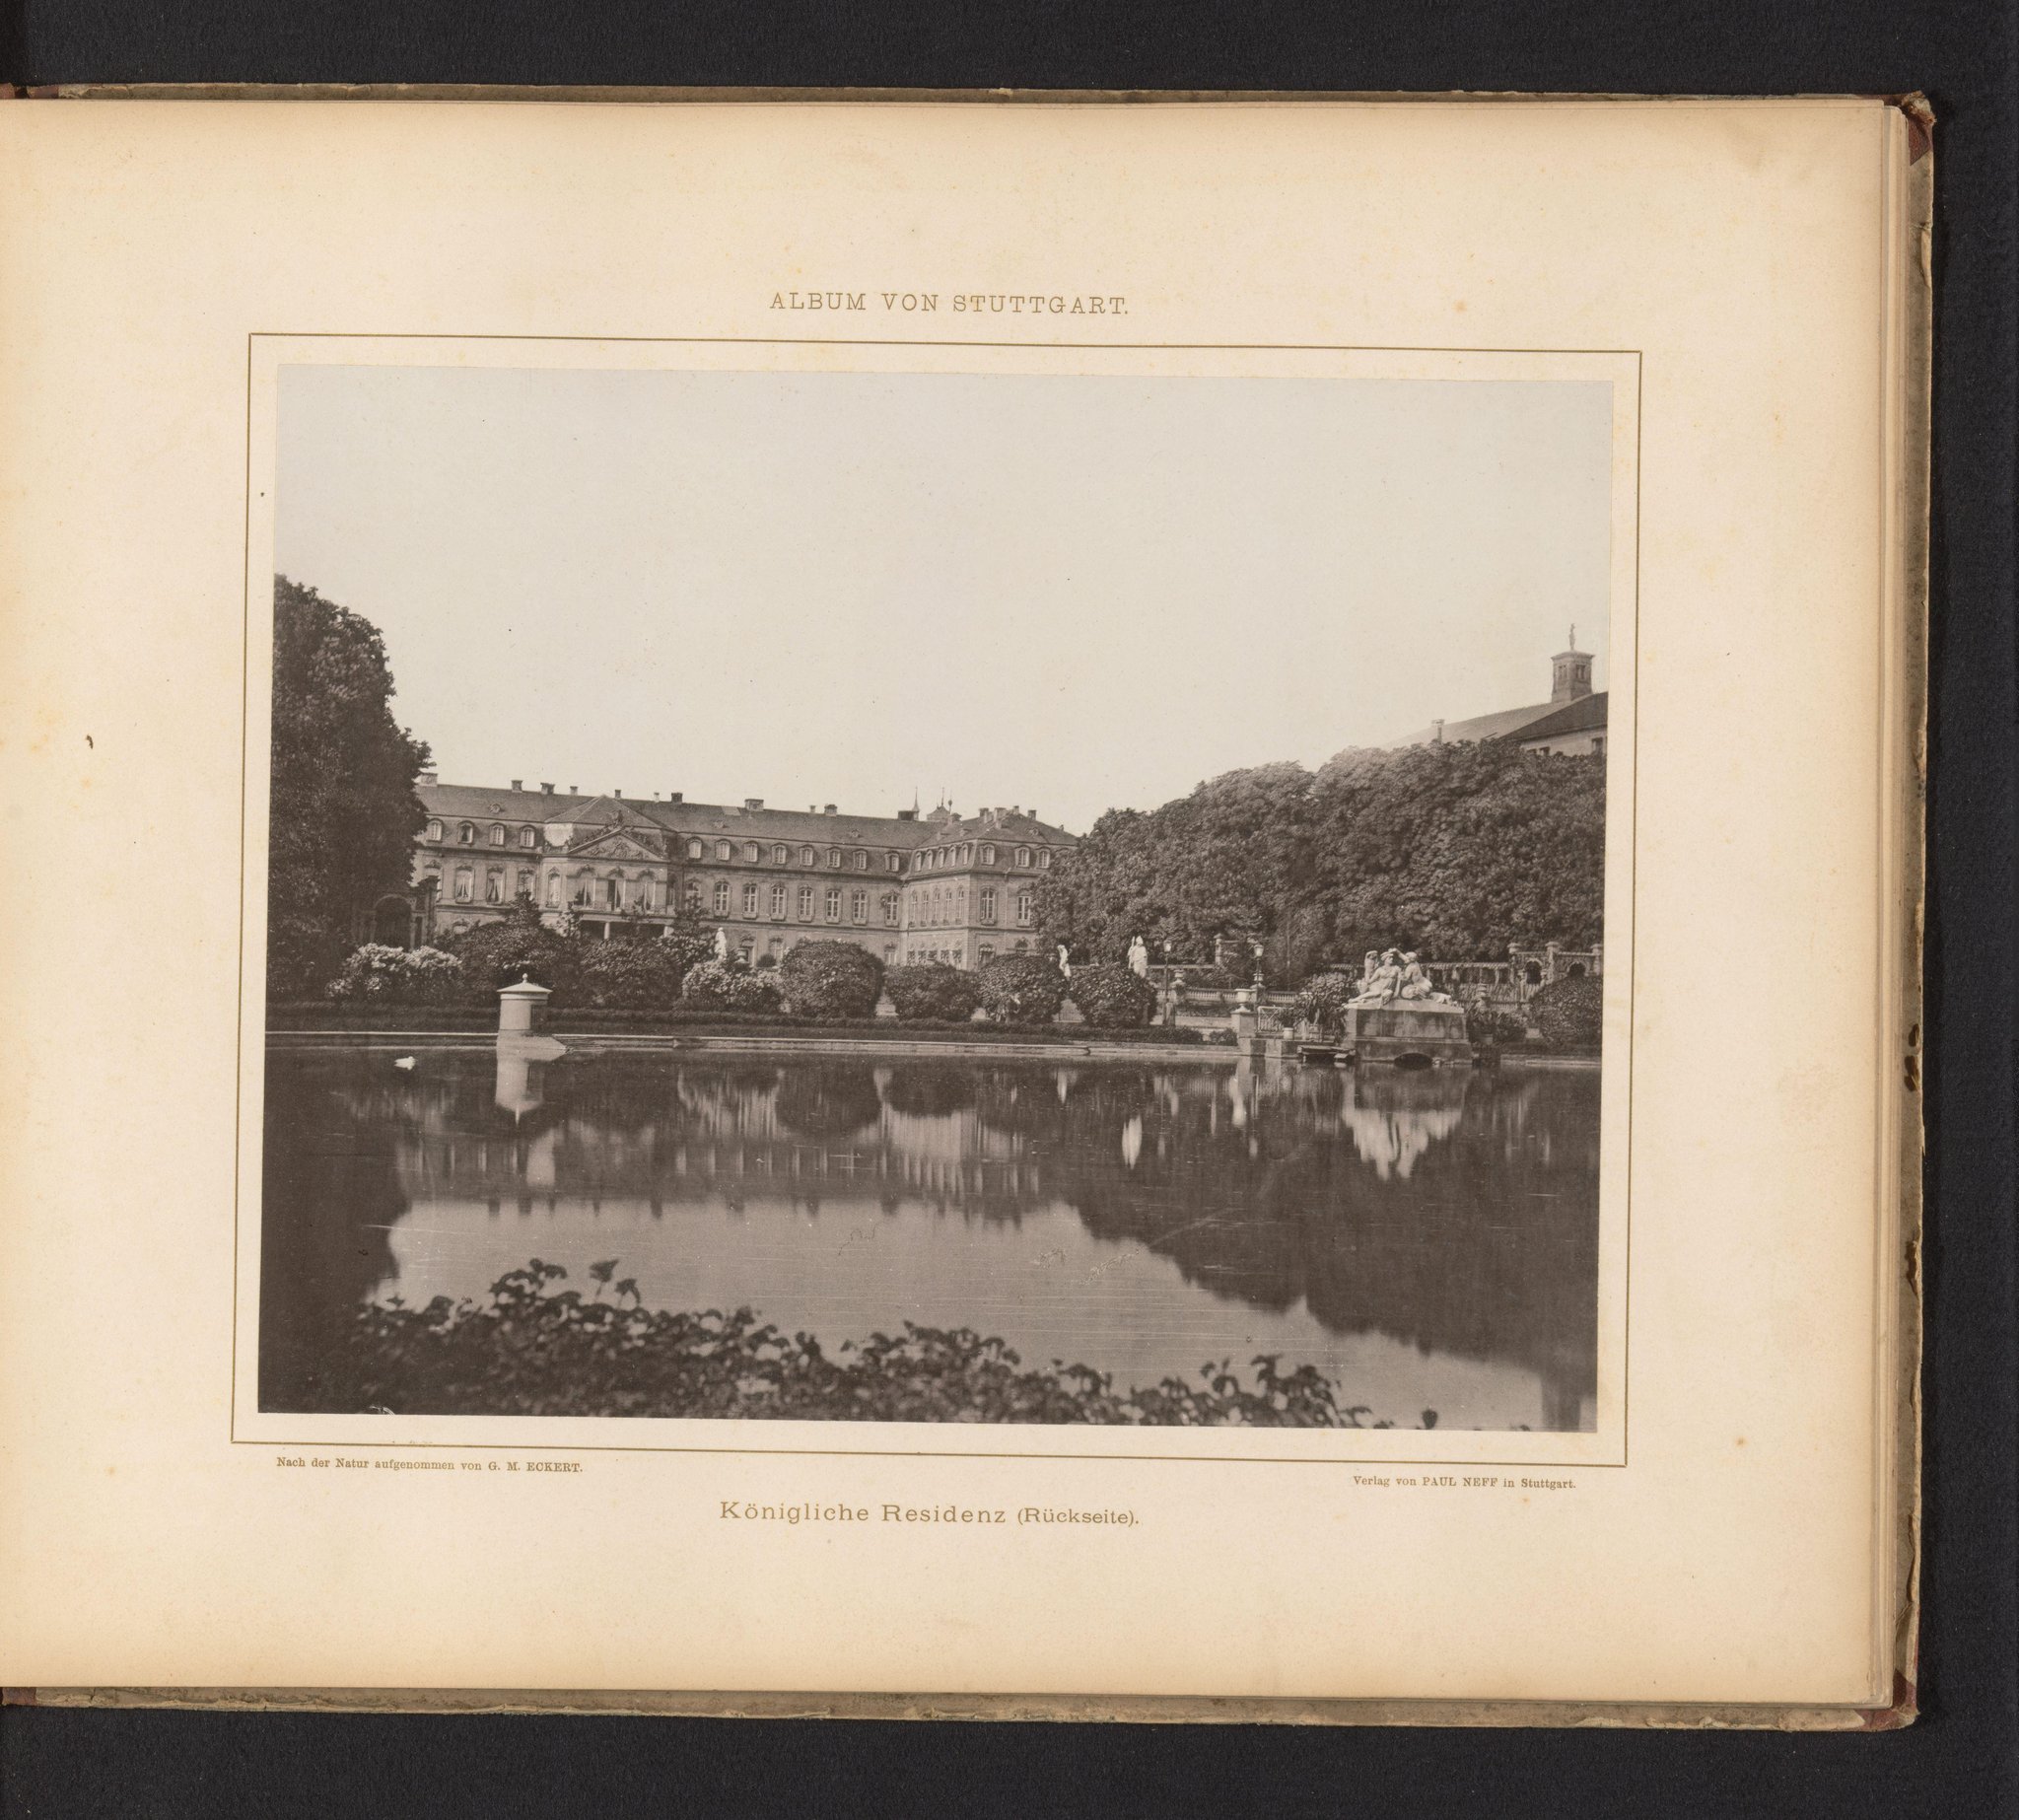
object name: page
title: Gezicht op het Nieuwe Kasteel in Stuttgart, Duitsland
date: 1870-1875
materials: paper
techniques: photograph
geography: stuttgart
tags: palace